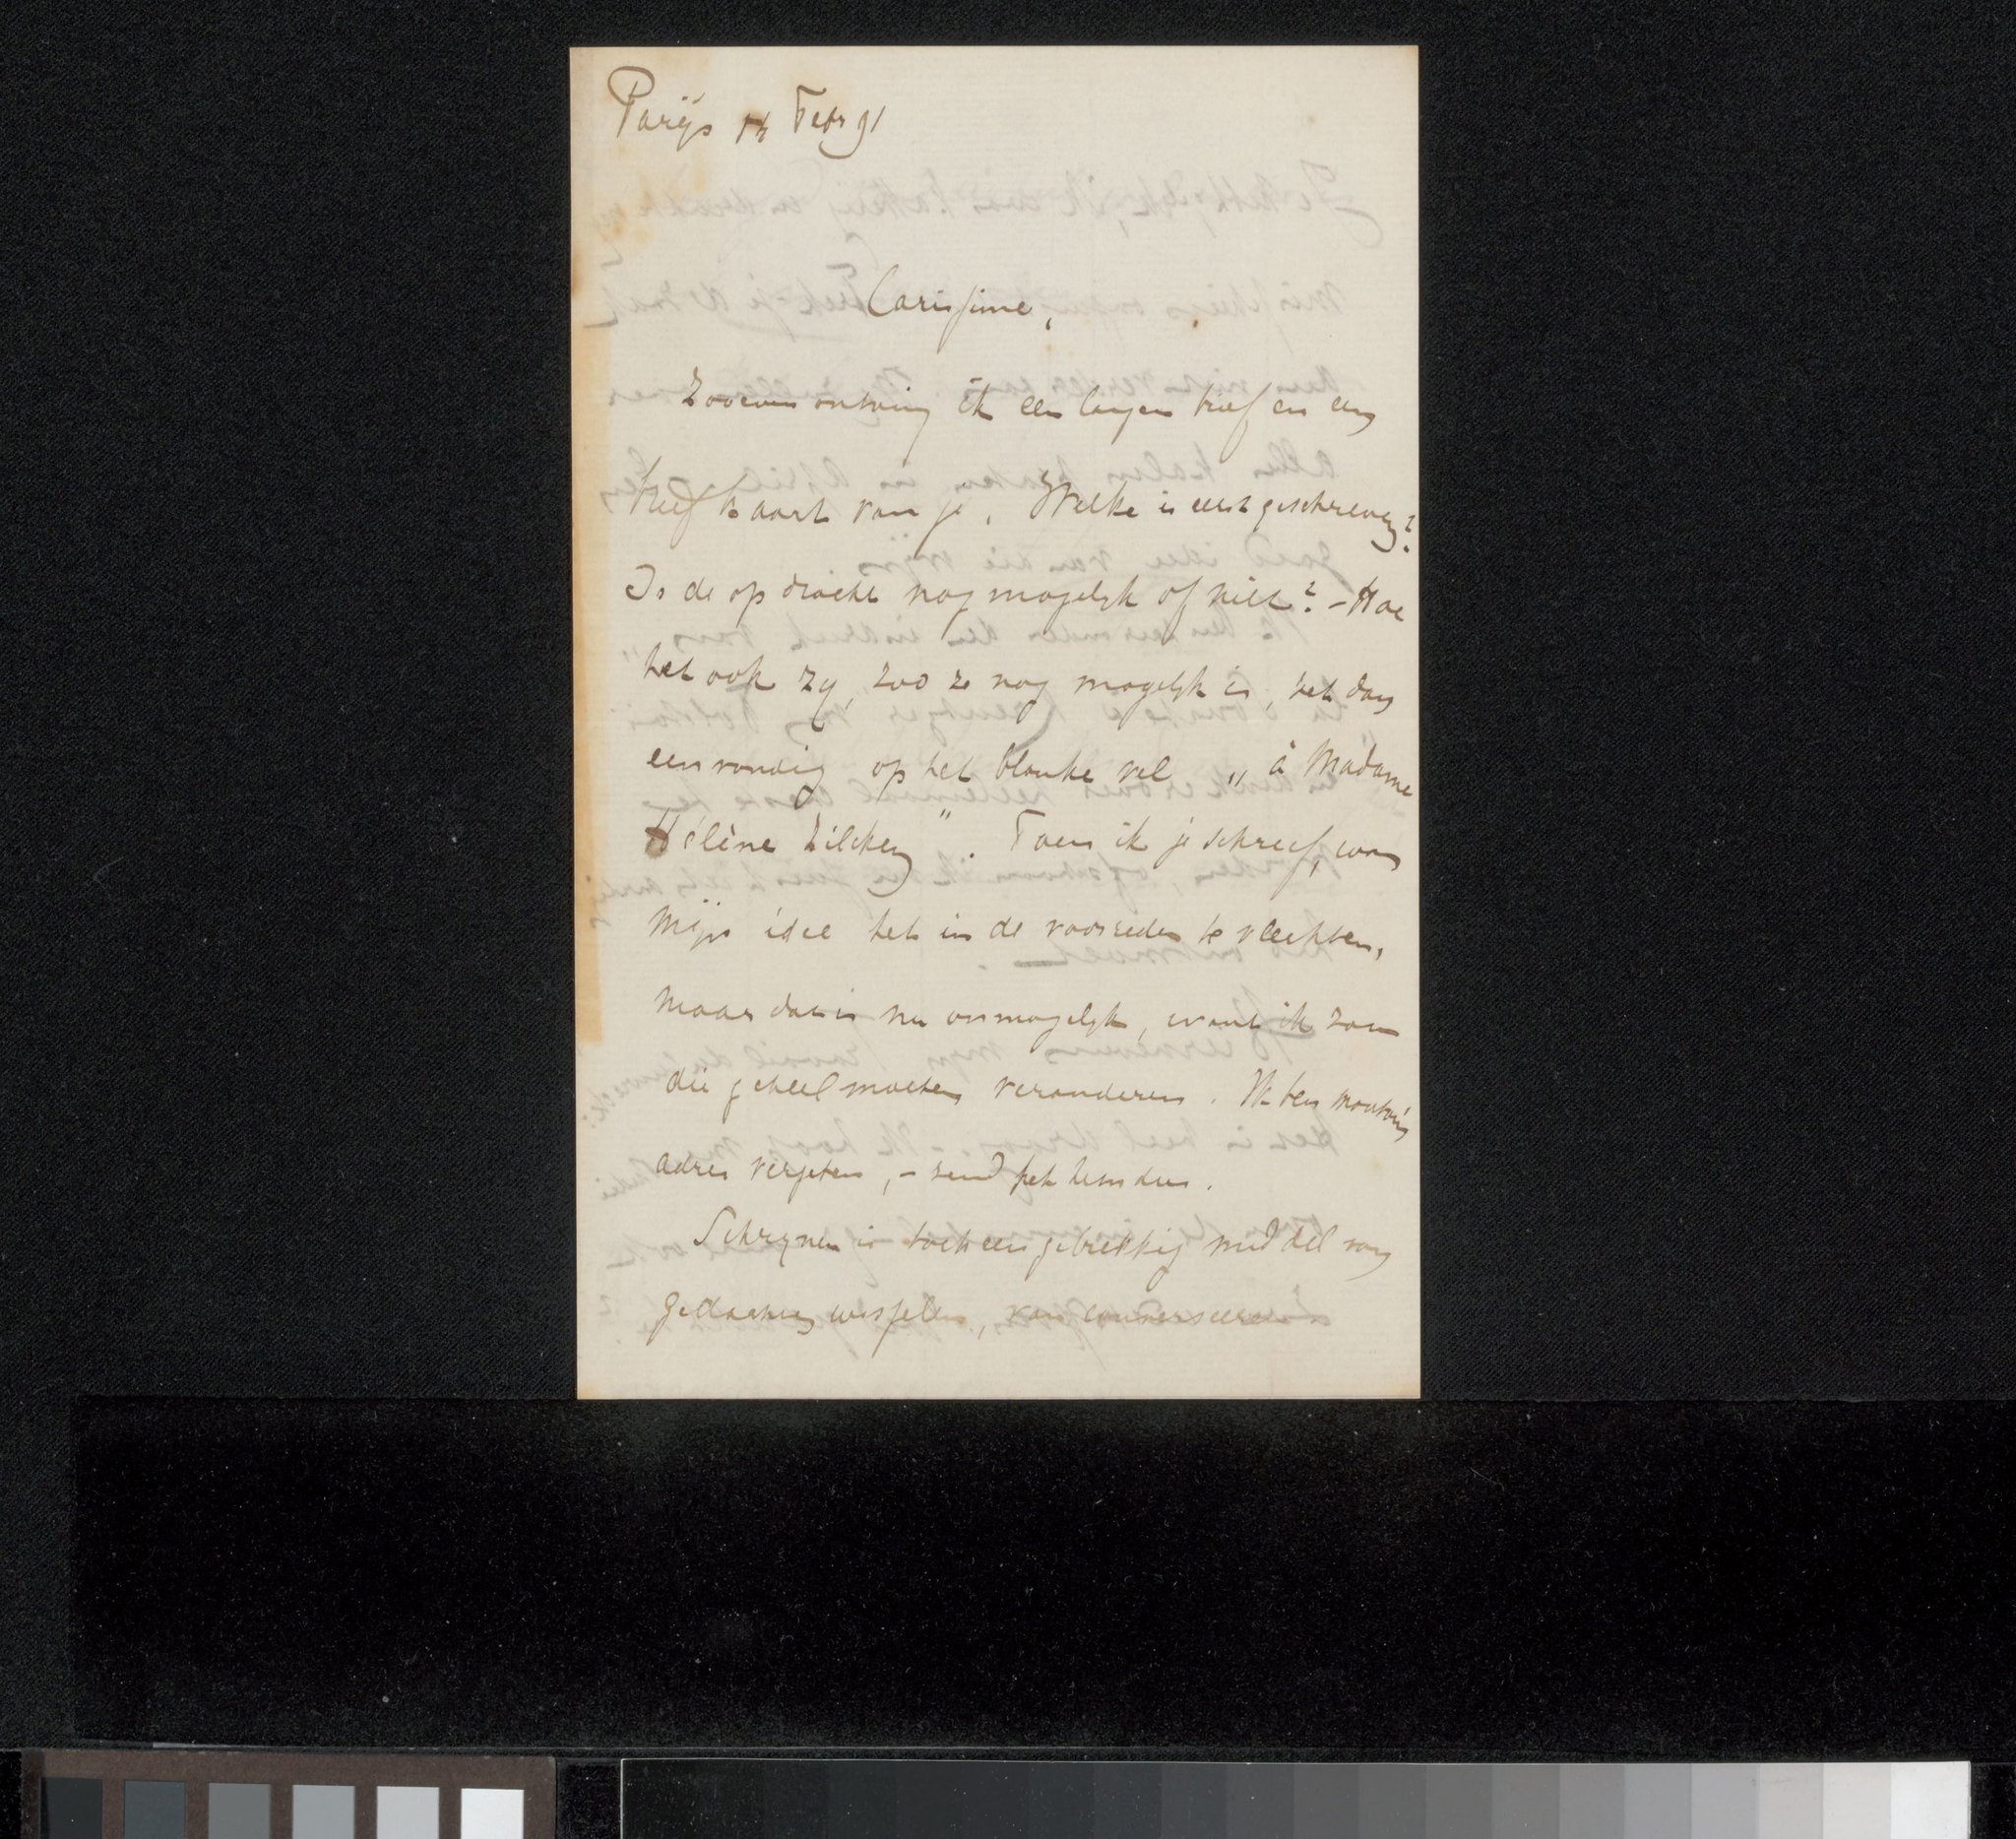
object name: letter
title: Brief aan Philip Zilcken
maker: adriaan pit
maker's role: print maker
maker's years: 1860-1944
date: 1891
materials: ink, paper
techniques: pen, writing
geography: paris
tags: renée hélène laure zilcken, politician, jules destrée, lev tolstoj, the hague, painter, draughtsman, philip zilcken, printed matter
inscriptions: collector's mark: ‘RPK’, watermark